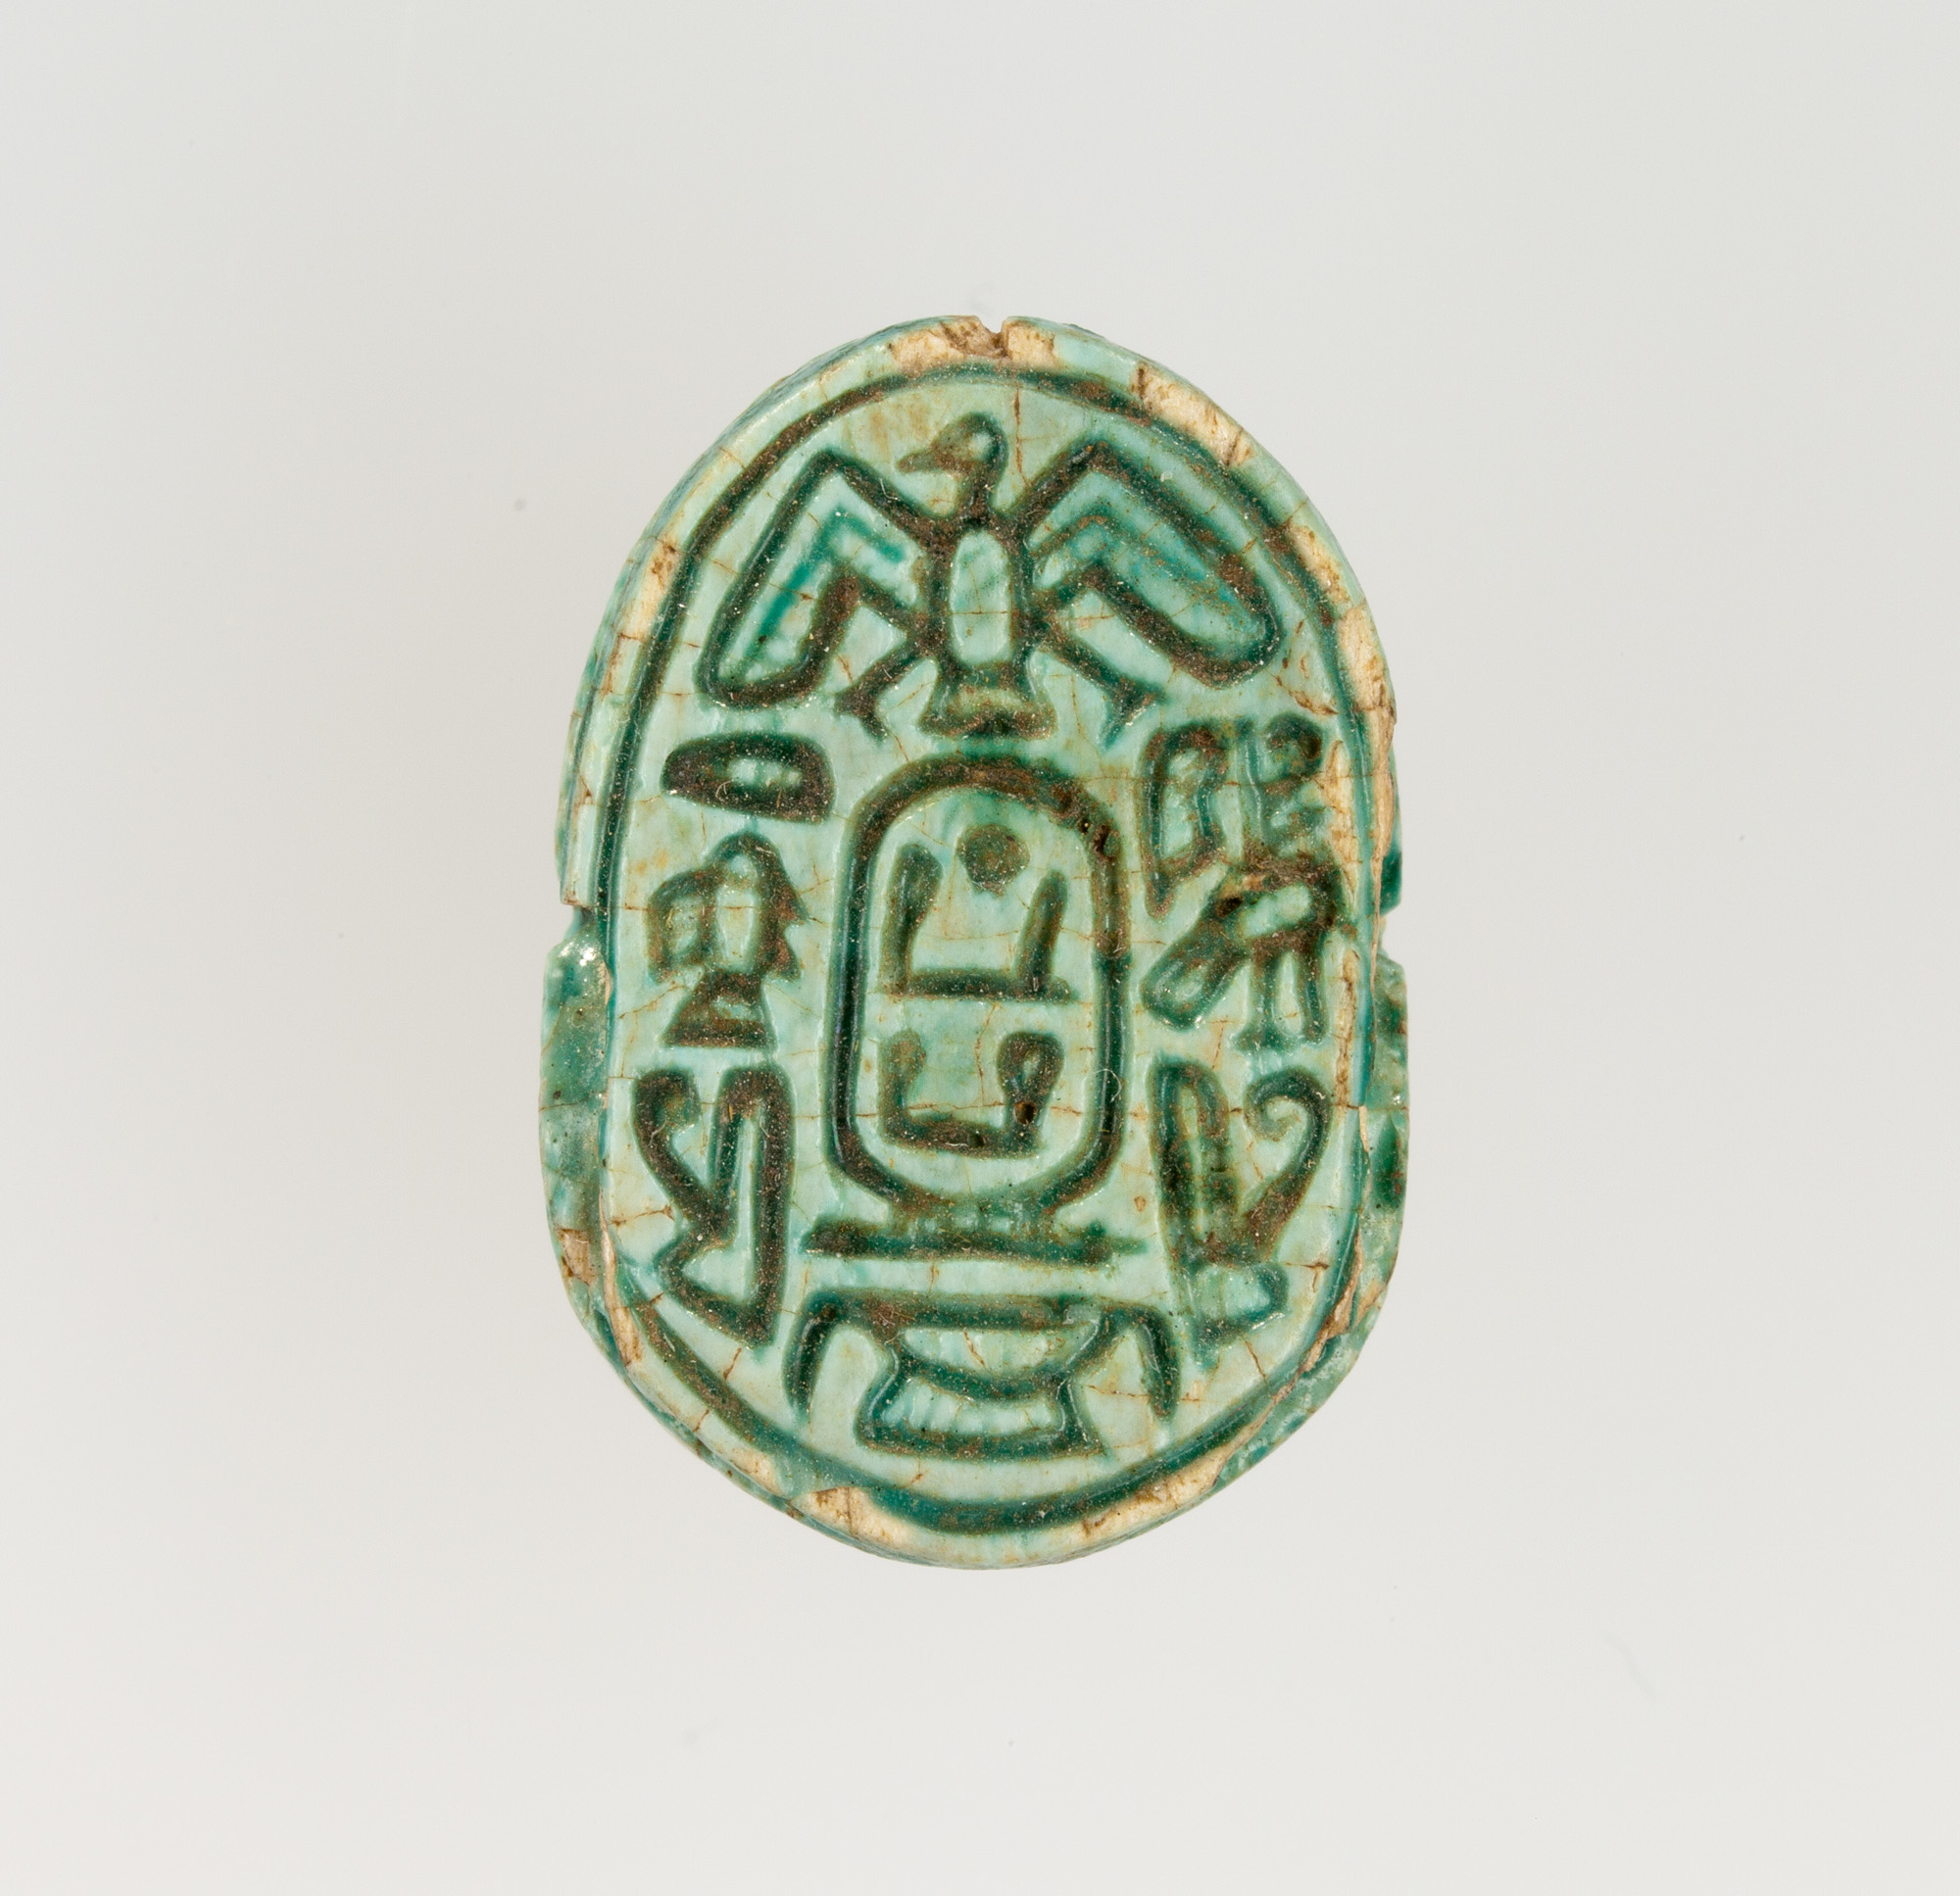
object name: scarab, amenhotep i, djeserkare, vulture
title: Scarab Inscribed with the Throne Name of Amenhotep I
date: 1525-1504 BCE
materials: stone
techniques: glazing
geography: egypt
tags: hieroglyphs,scarabs